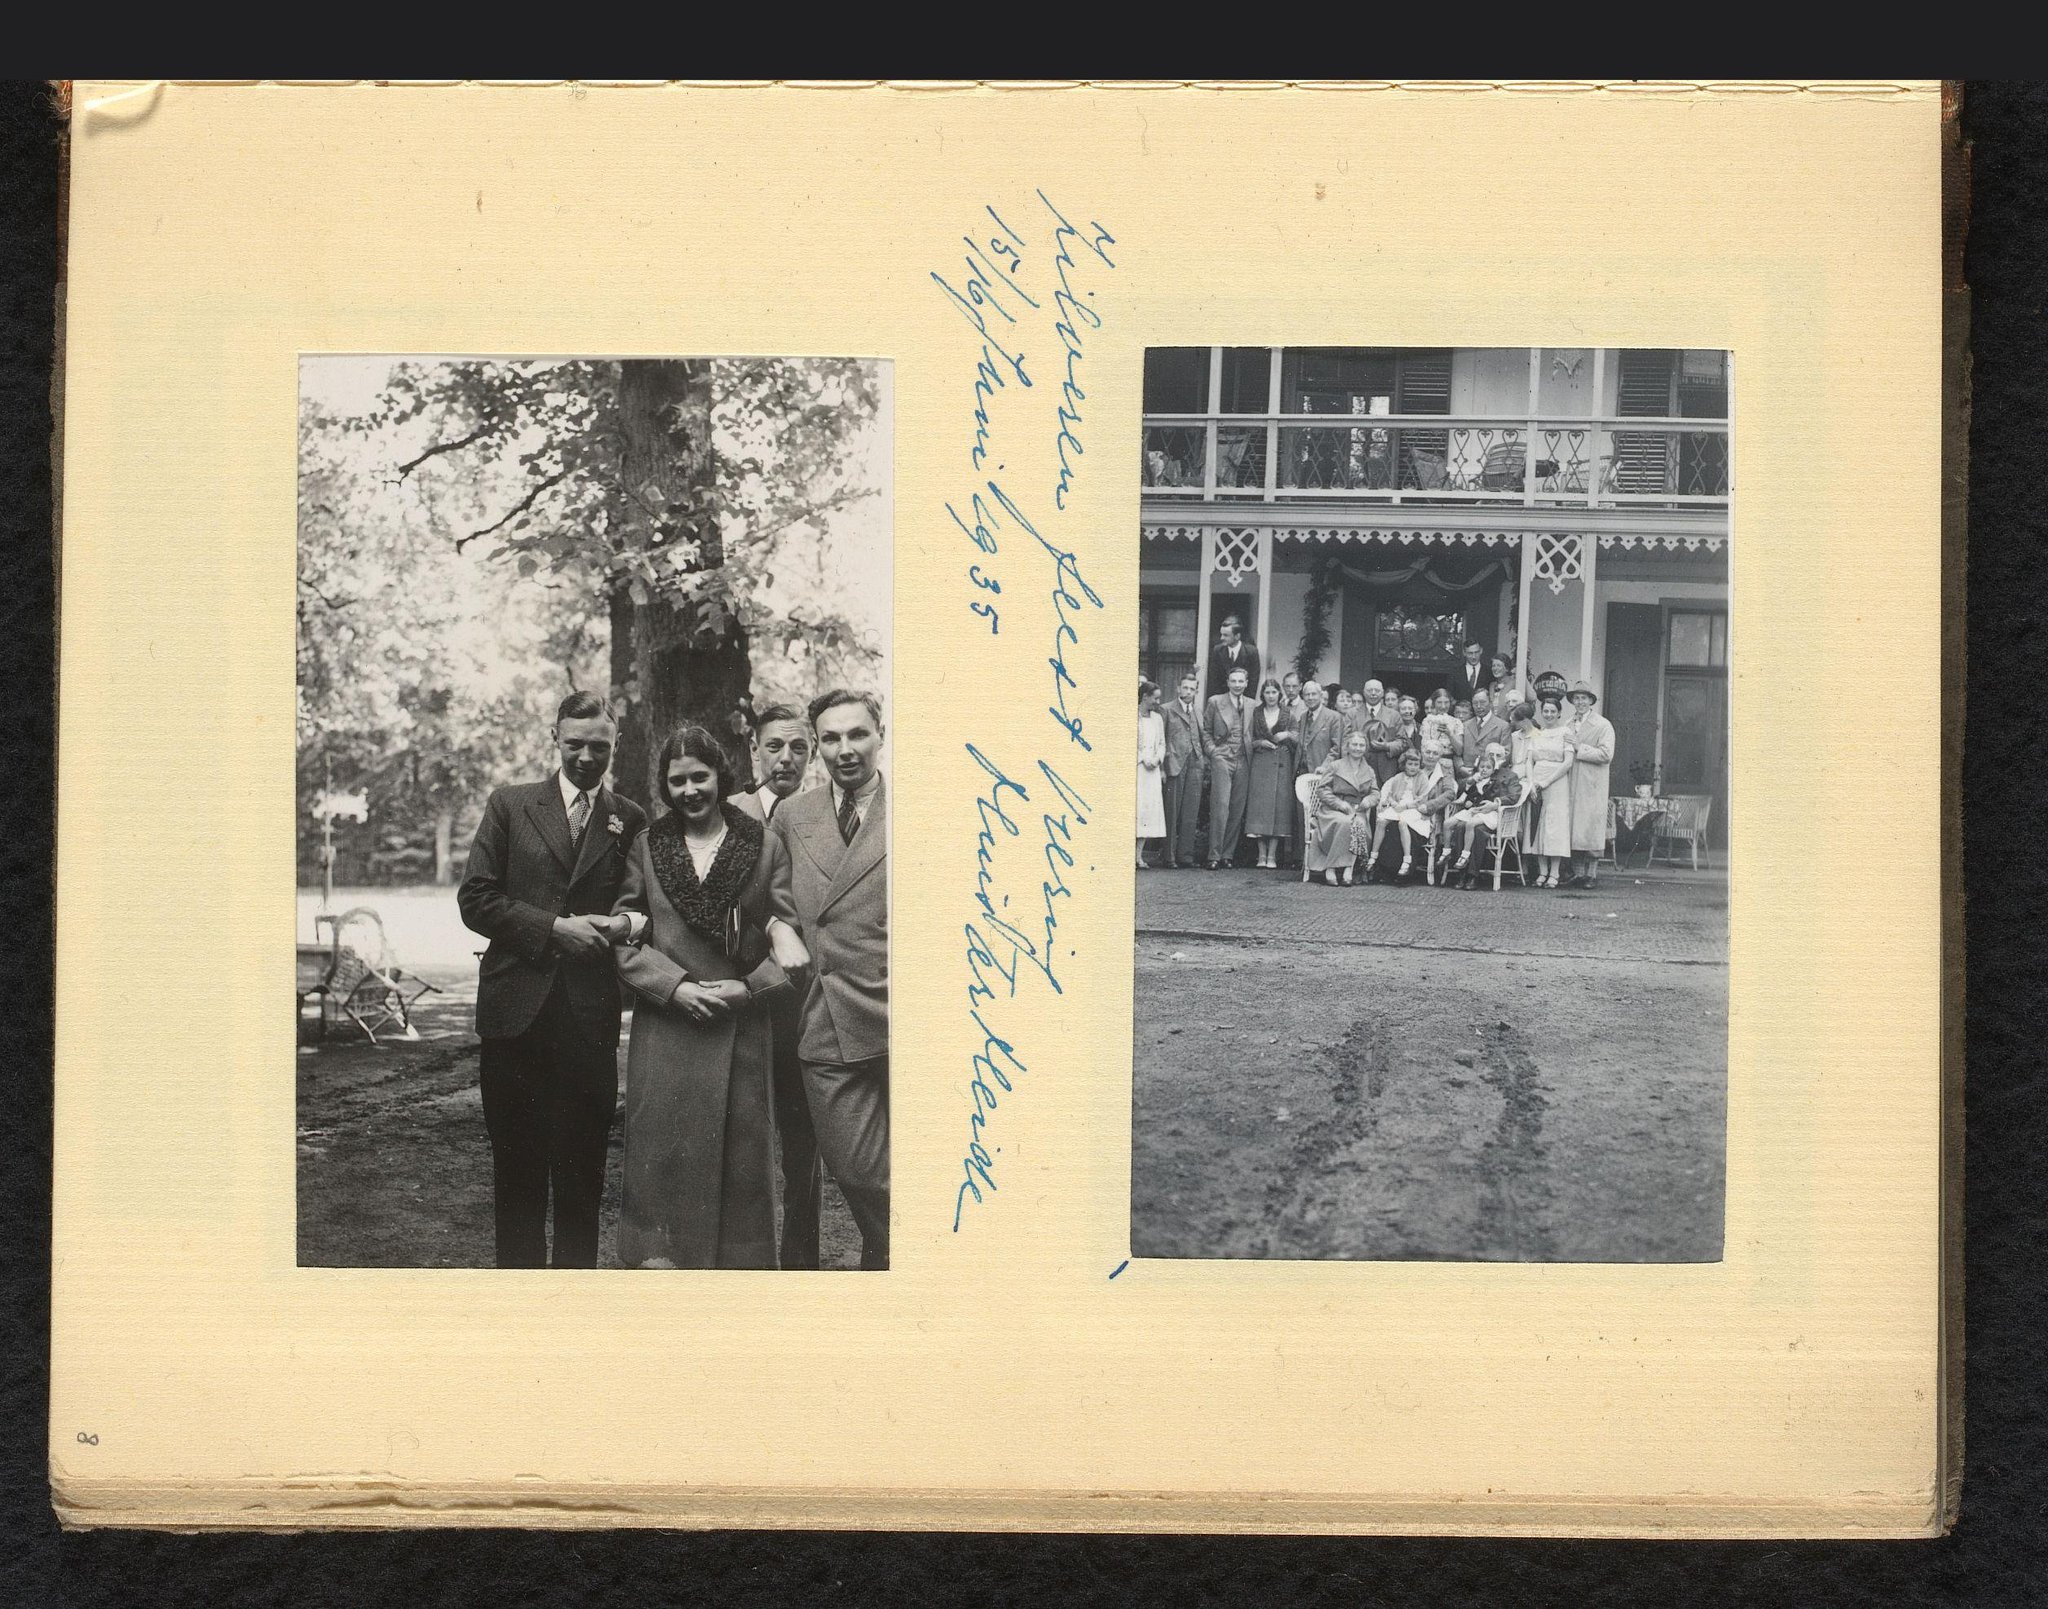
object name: photograph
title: Twee groepsportretten bij een familiefeest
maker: Anonymous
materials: paper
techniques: gelatin silver print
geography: huis ter heide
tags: silver anniversary, family life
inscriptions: inscription: ‘Zilveren feest viering/ 15/16 Juni 1935 Huis ter Heide’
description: Deze foto's maken deel uit van een album.